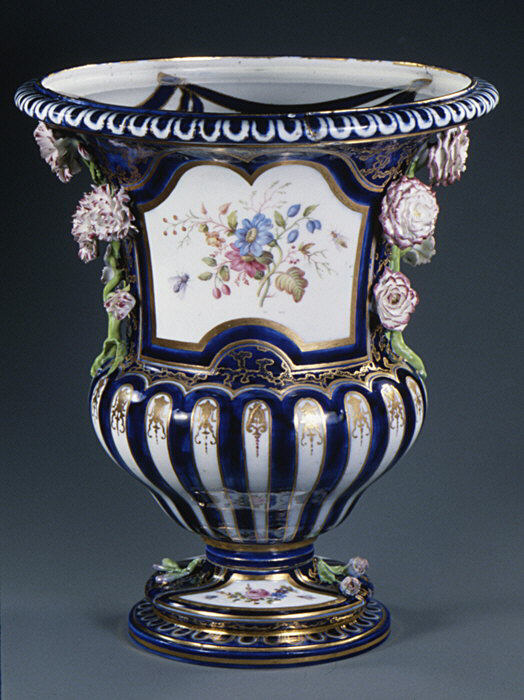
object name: vase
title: Vase (vase le boitteux)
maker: vincennes manufactory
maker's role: manufactory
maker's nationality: french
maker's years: 1740-1756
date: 1752-1753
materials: soft paste porcelain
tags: flowers